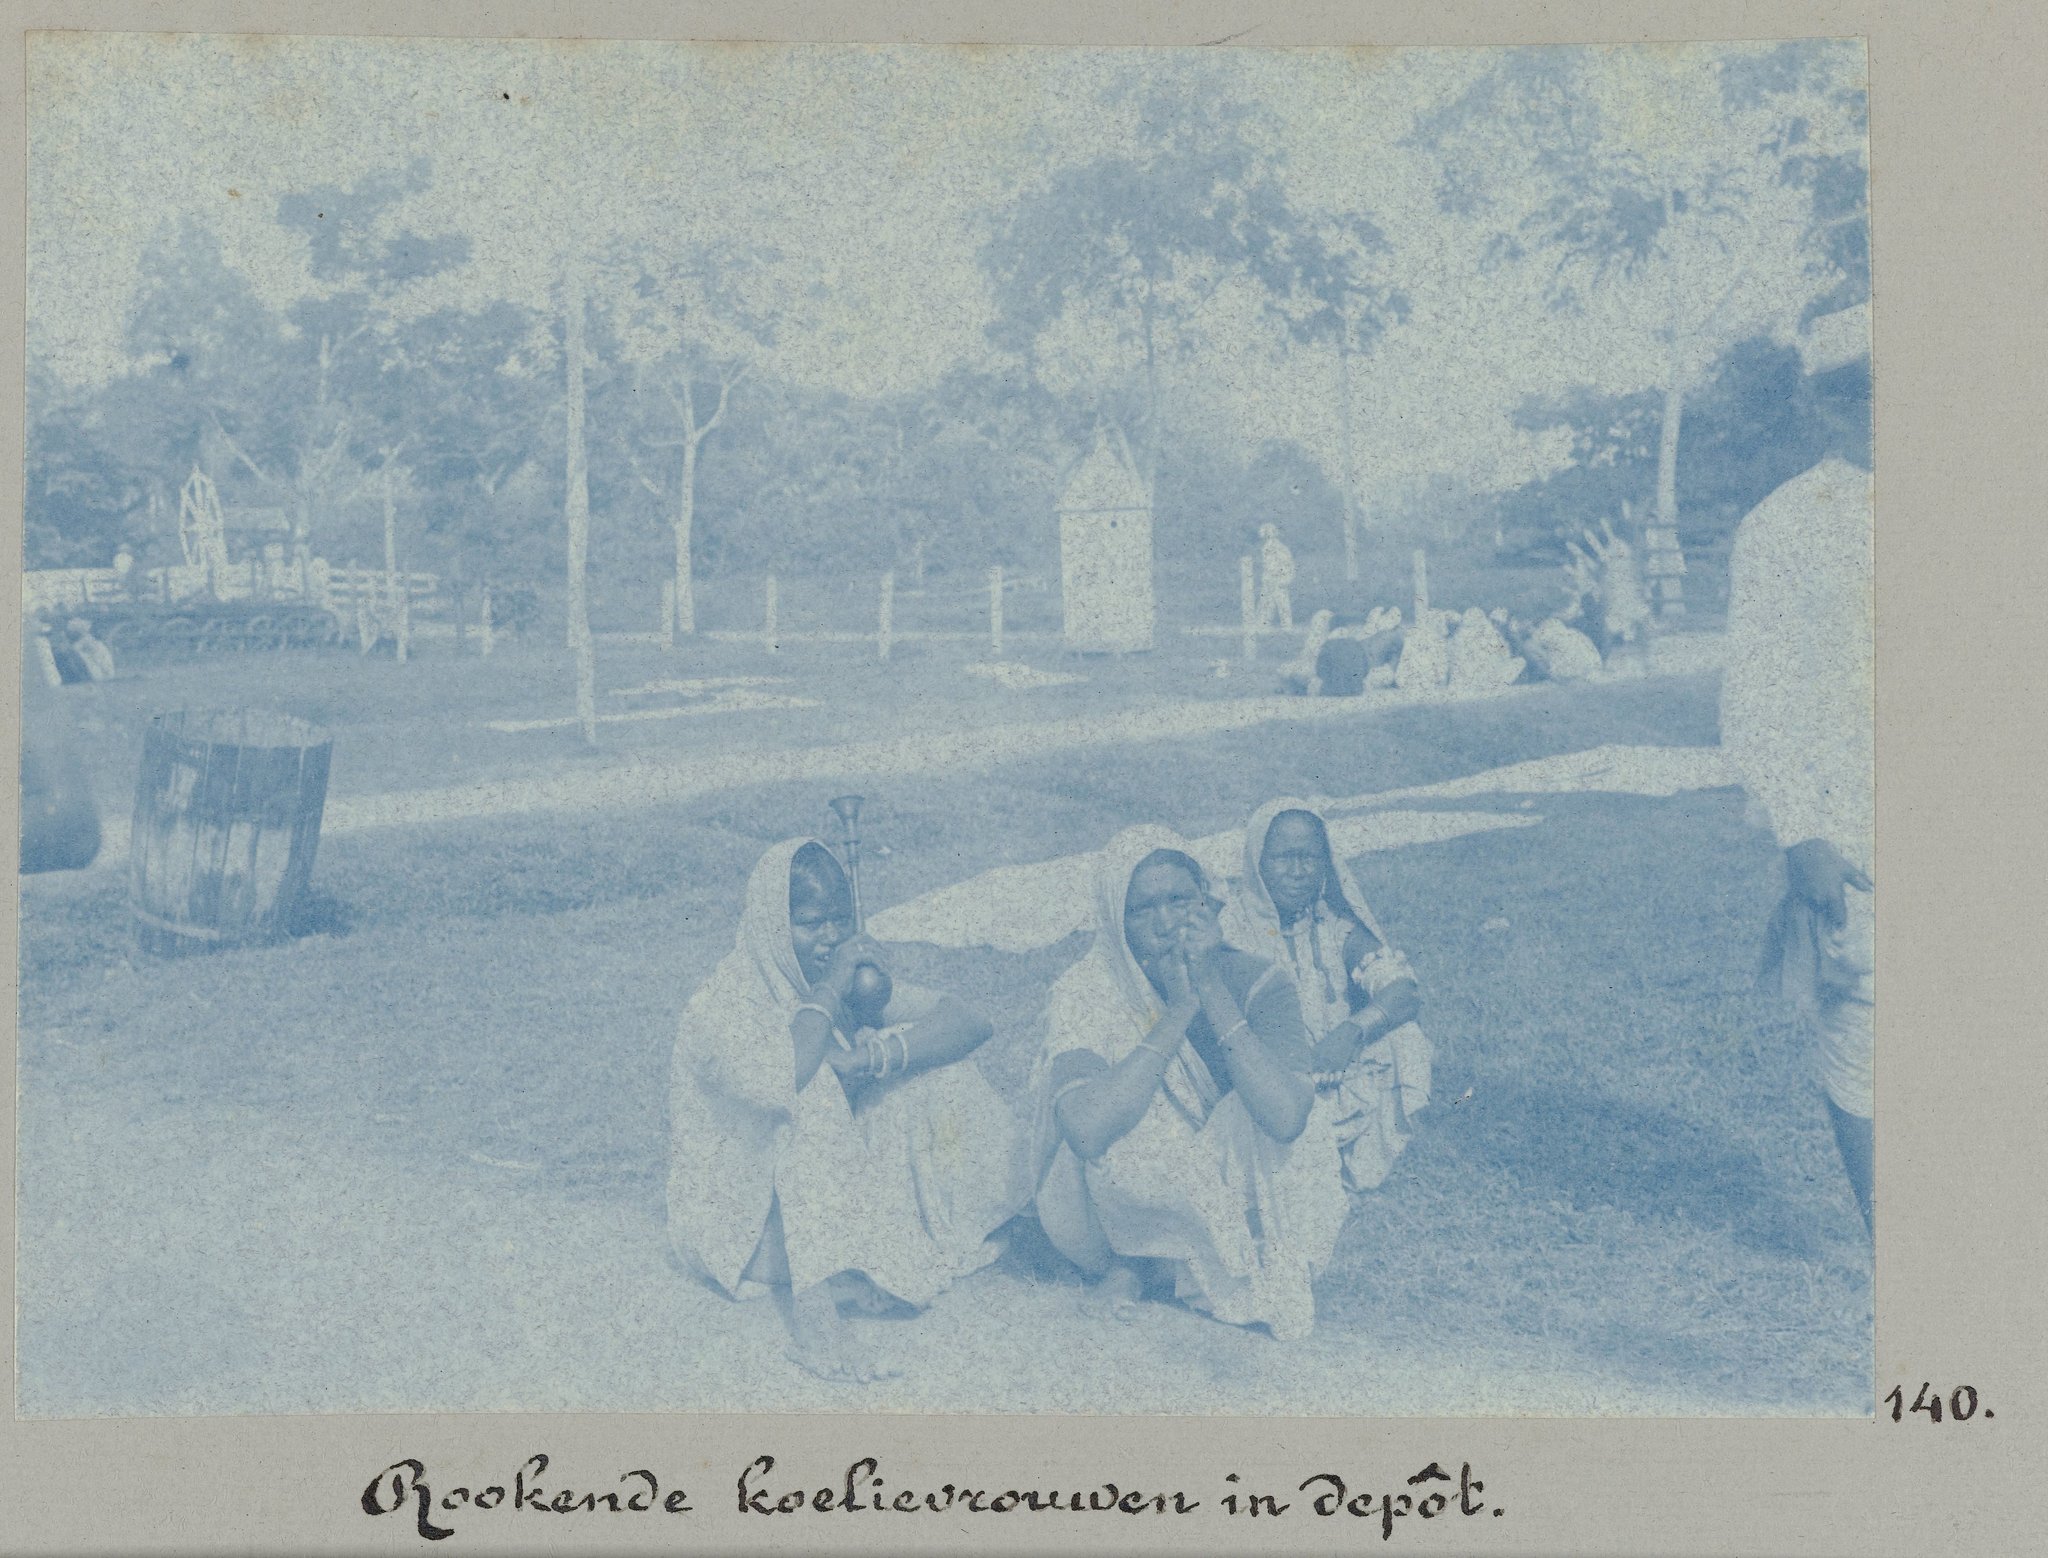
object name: photograph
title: Rokende vrouwen in het immigrantendepot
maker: hendrik doijer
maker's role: engineer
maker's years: 1863-1925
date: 1903-1910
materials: photographic support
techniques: cyanotype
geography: suriname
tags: suriname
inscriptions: inscription: ‘140. / Rookende koelievrouwen in depôt.’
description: Enkele vrouwen roken (een soort pijp) zittend op de grond, in het zgn. ‘koeliedepot’ het centrale verzamelpunt voor immigranten te Paramaribo te Paramaribo. Onderdeel van het fotoalbum Souvenir de Voyage (deel 5), over het leven van de familie Doijer in en rond de plantage Ma Retraite in Suriname in de jaren 1903-1910.